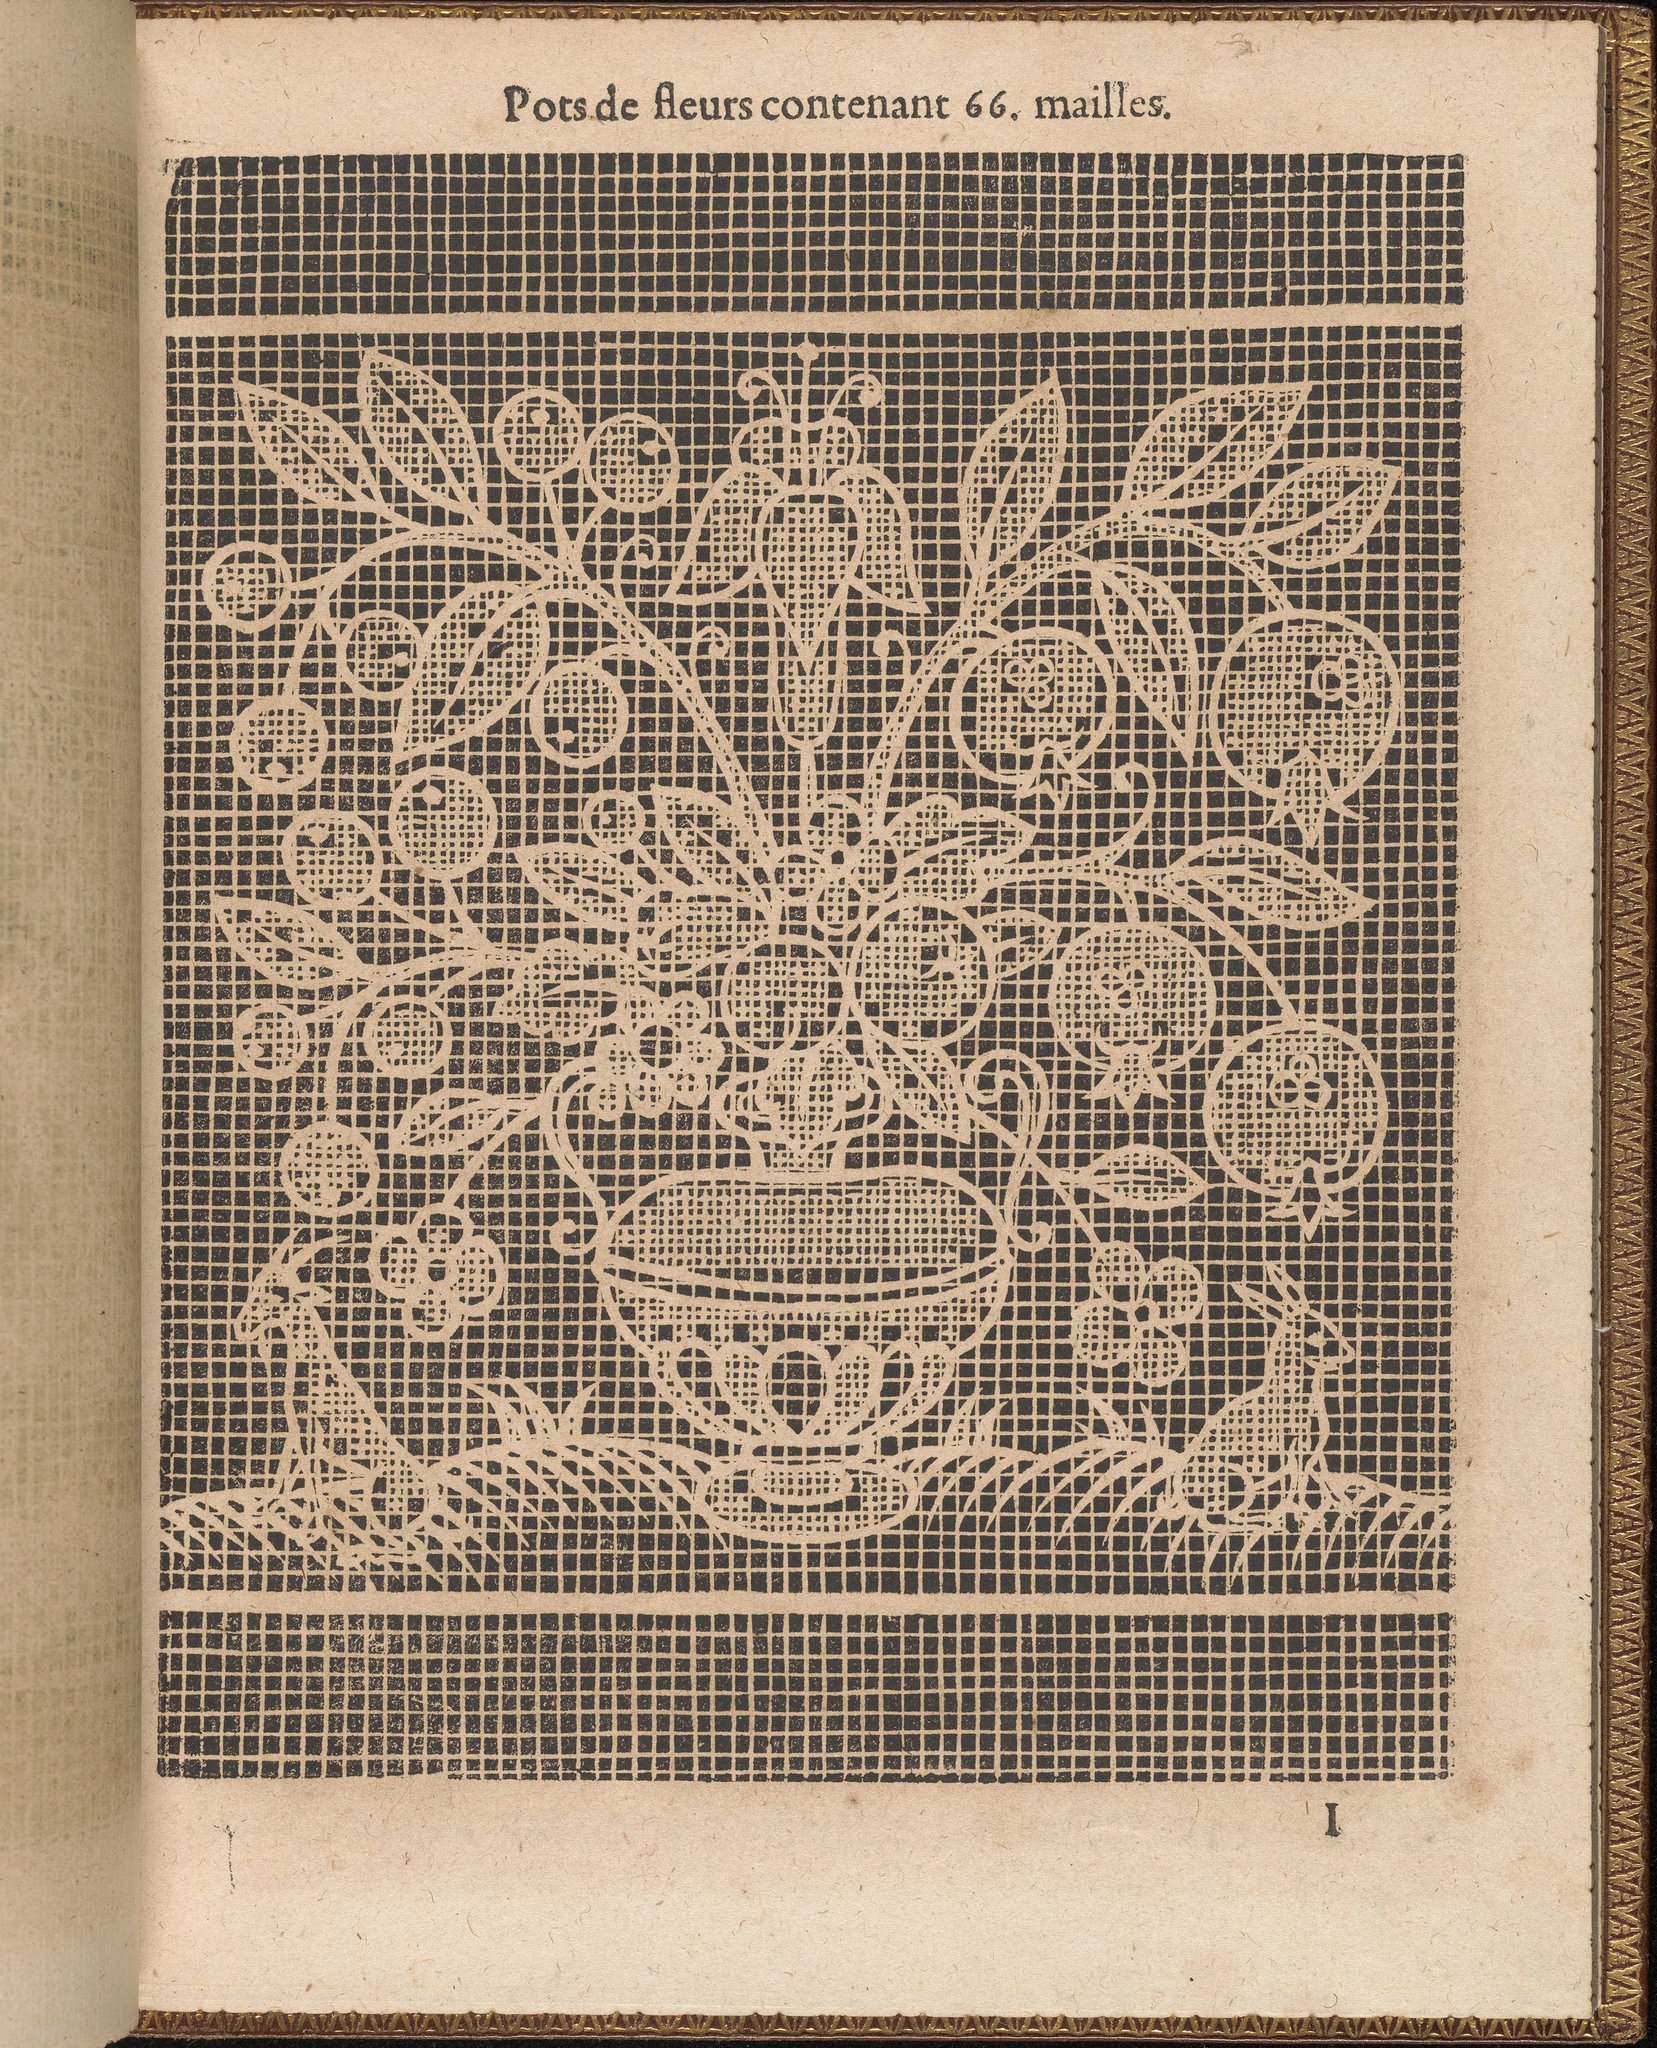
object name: book print ornament architecture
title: La Pratique de l'Aiguille, page 32 (recto)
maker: matthias mignerak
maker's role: author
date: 1605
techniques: woodcut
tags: fruit,goats,rabbits,plants